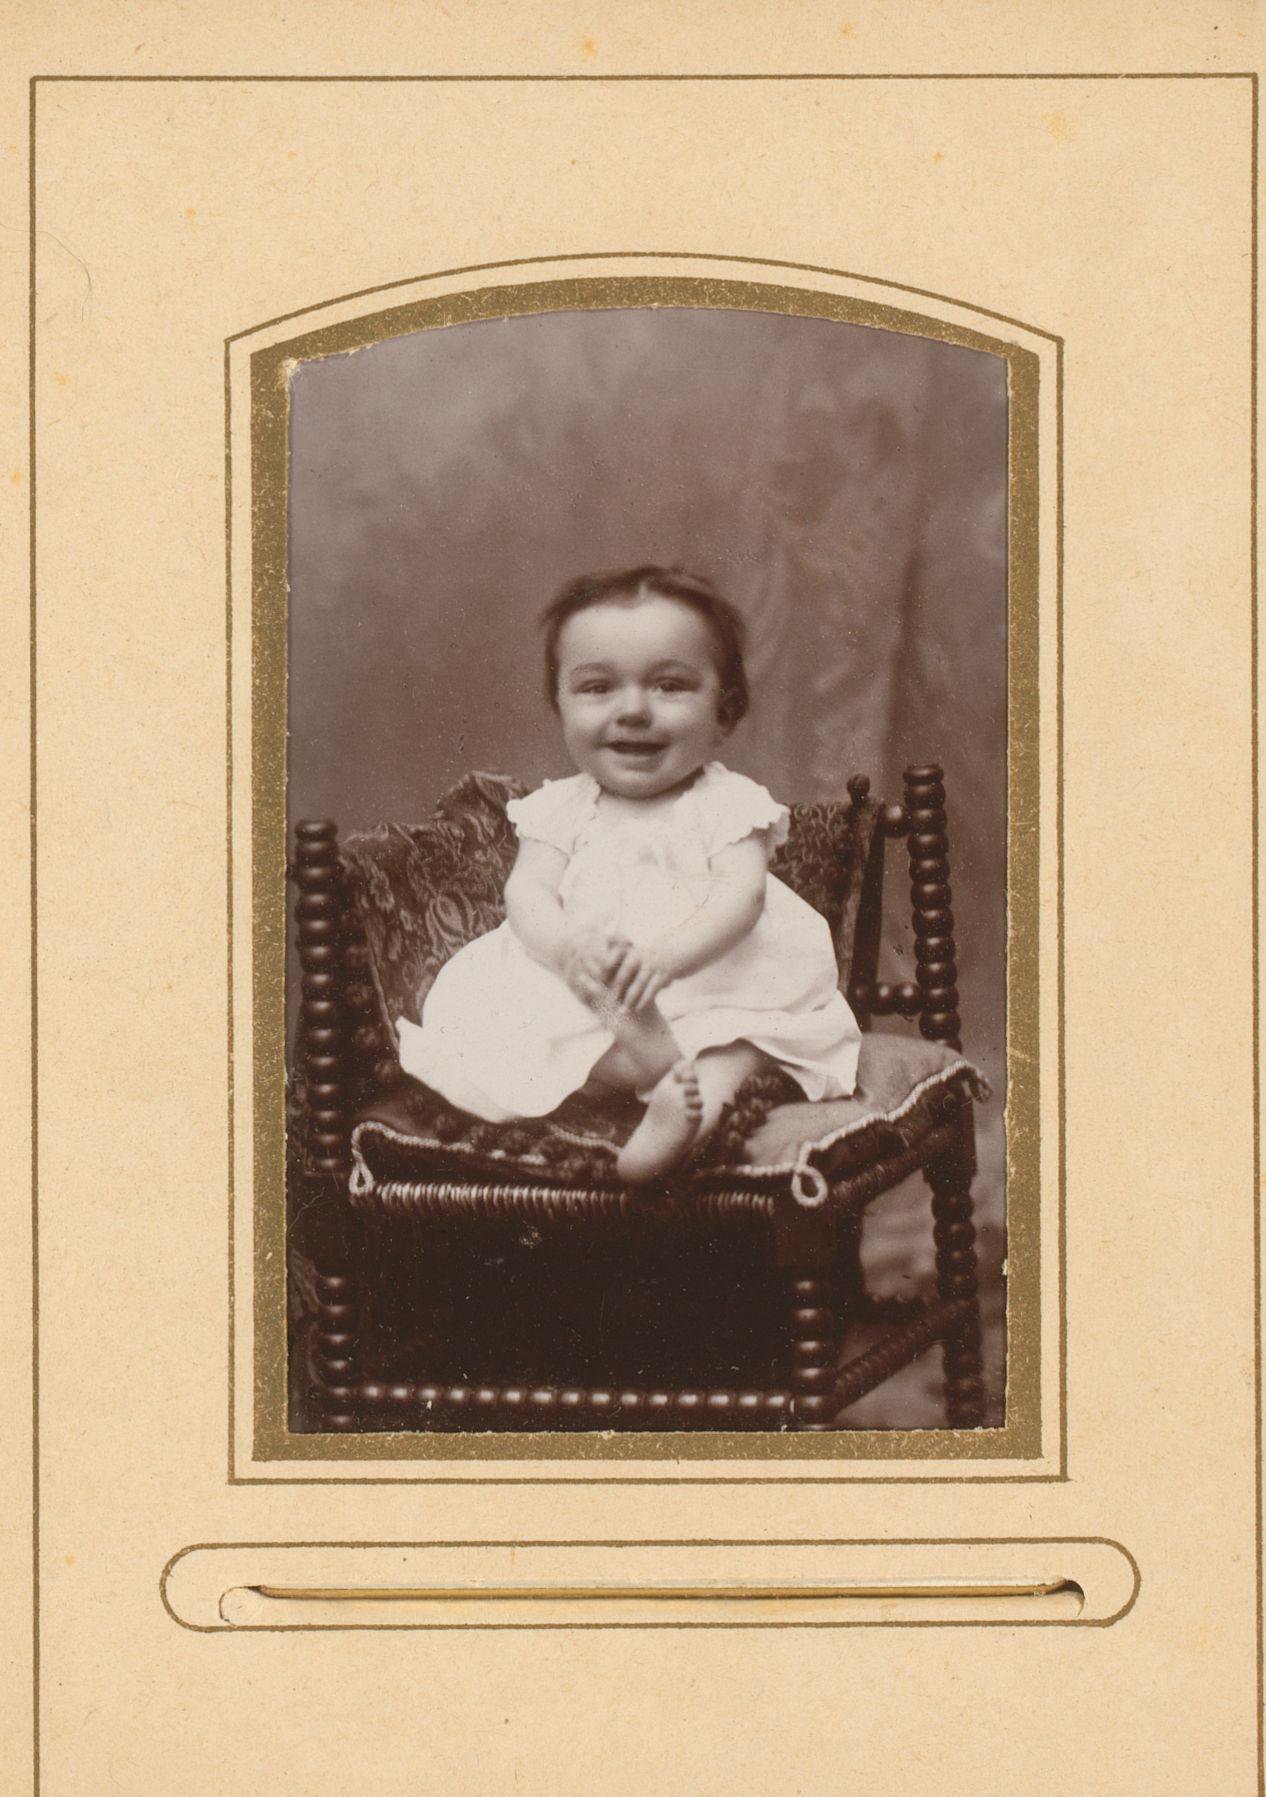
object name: album leaf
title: Portret van een zittende peuter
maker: Anonymous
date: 1880-1920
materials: cardboard, photographic support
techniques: collodion silver print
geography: france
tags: sitting figure, historical persons, tot, toddler ~ the ages of man